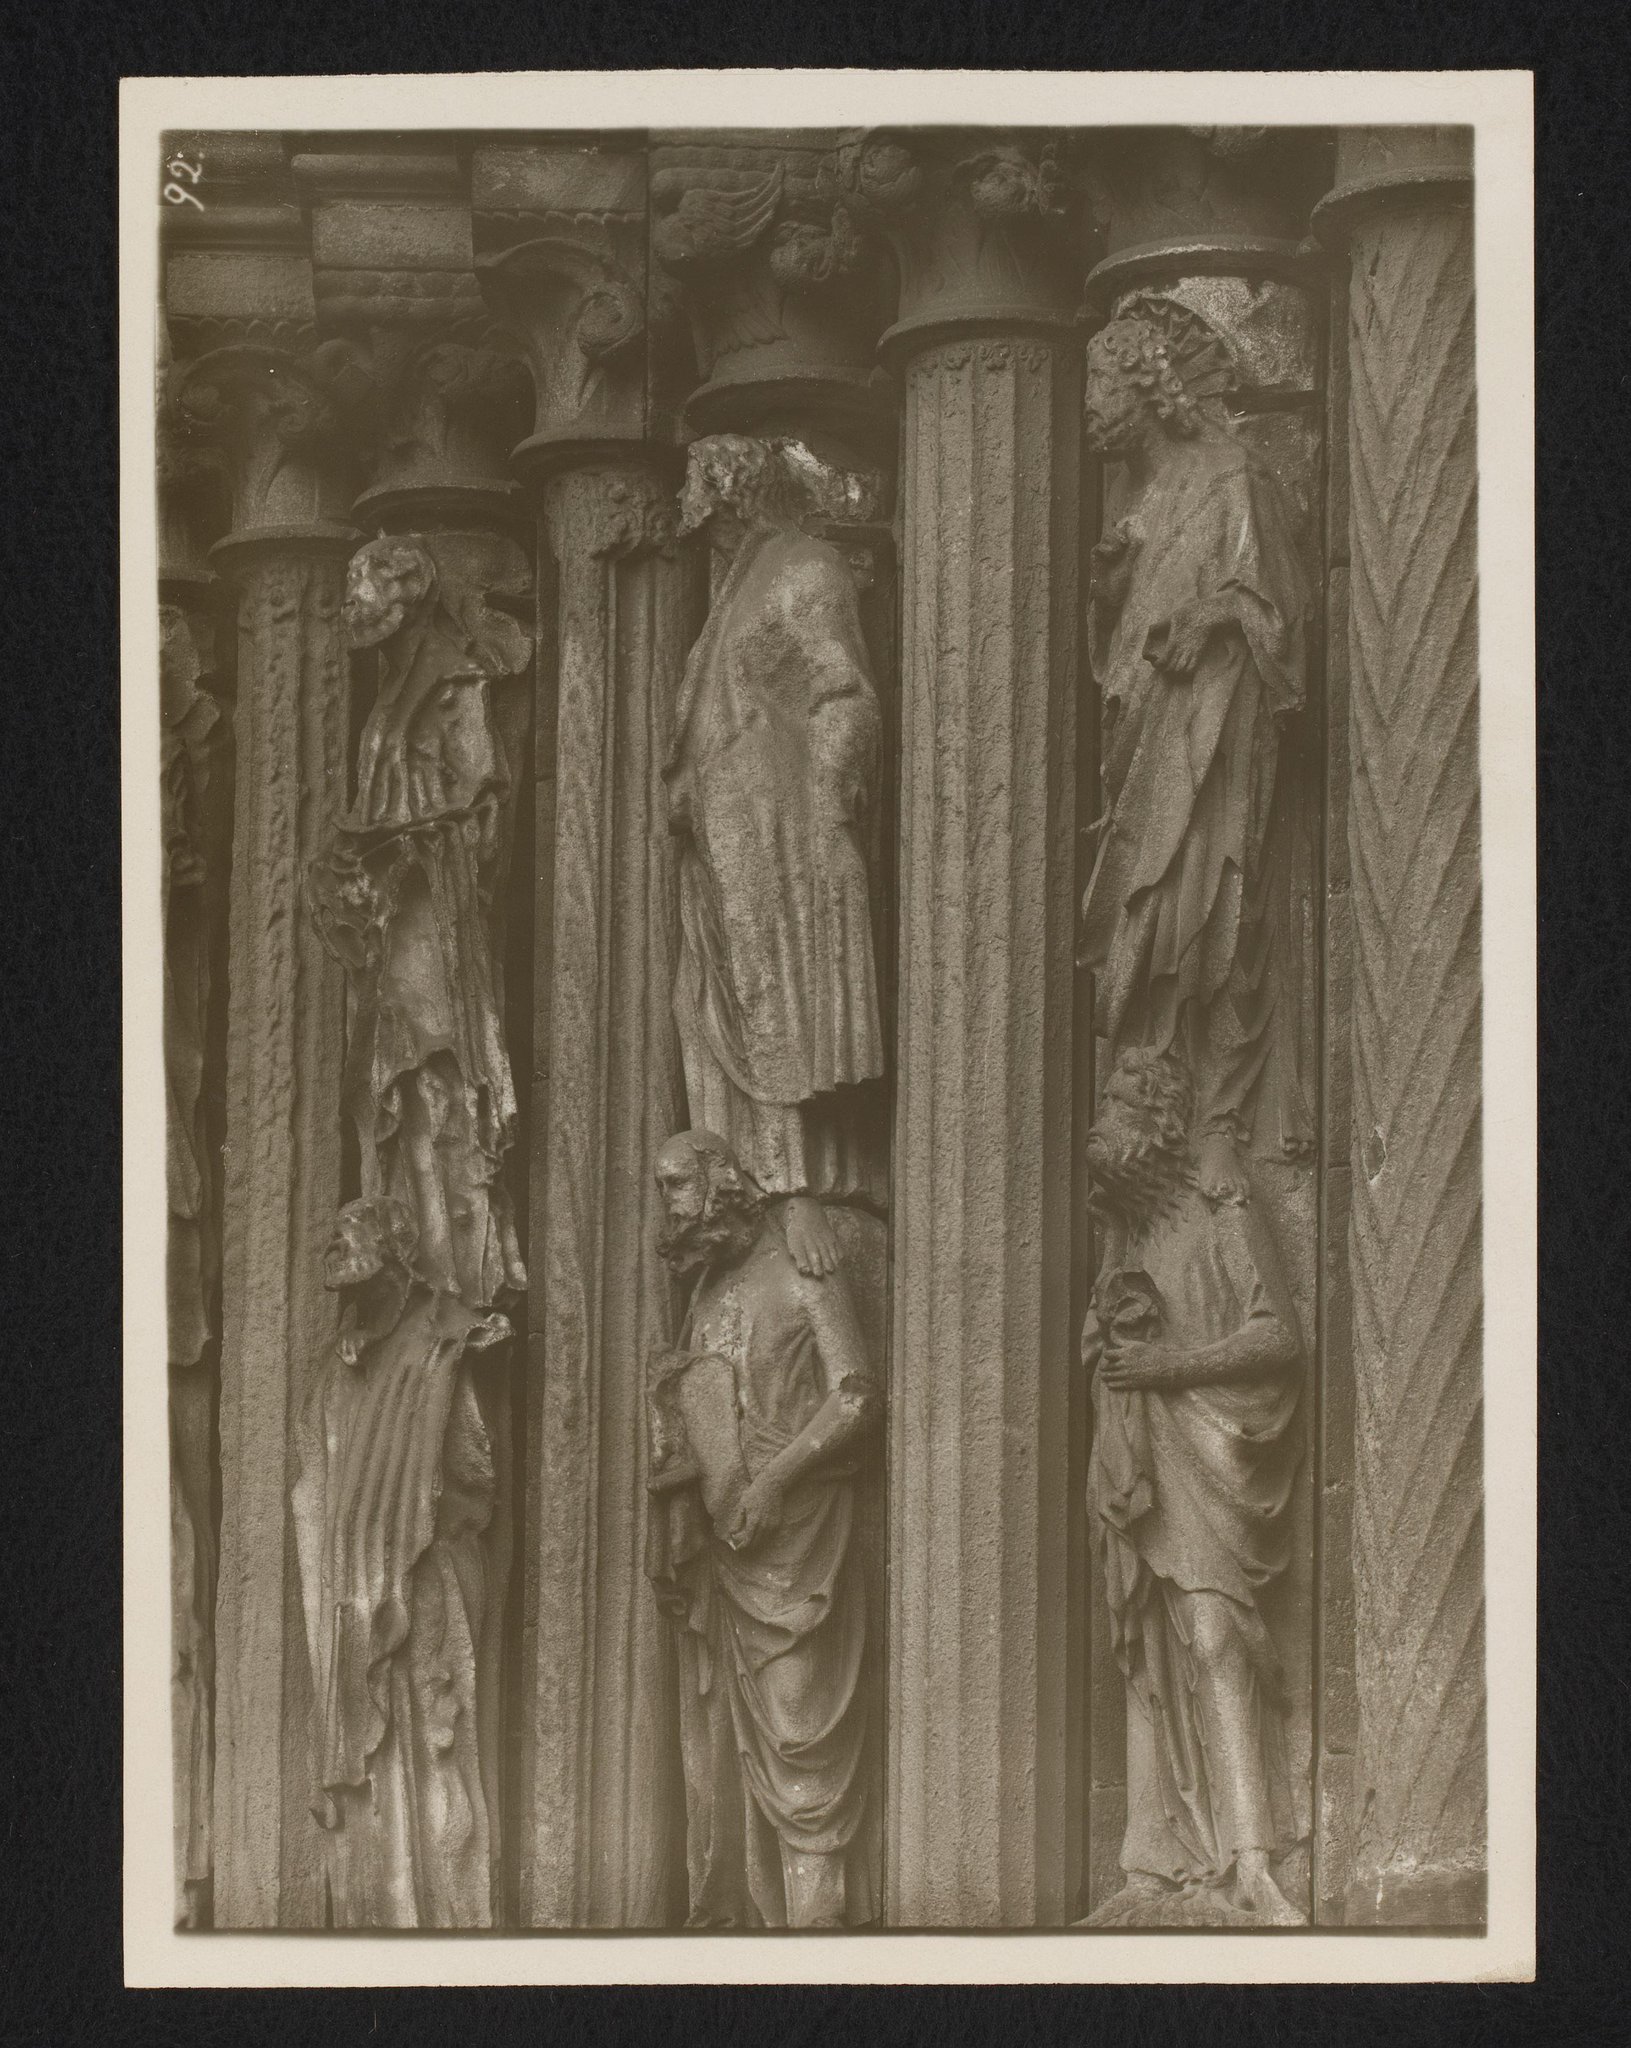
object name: album leaf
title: Fürstentor Statuen v. 2.3.4. v.N.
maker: Anonymous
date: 1900-1920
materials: paper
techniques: gelatin silver print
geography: bamberg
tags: church (exterior)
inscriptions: number: ‘92.’, inscription: ‘Kunsthist. Seminar/ Marburg (Lahn)/ Photogr. Abteilung/ Vervielfältigung/ untersagt.’